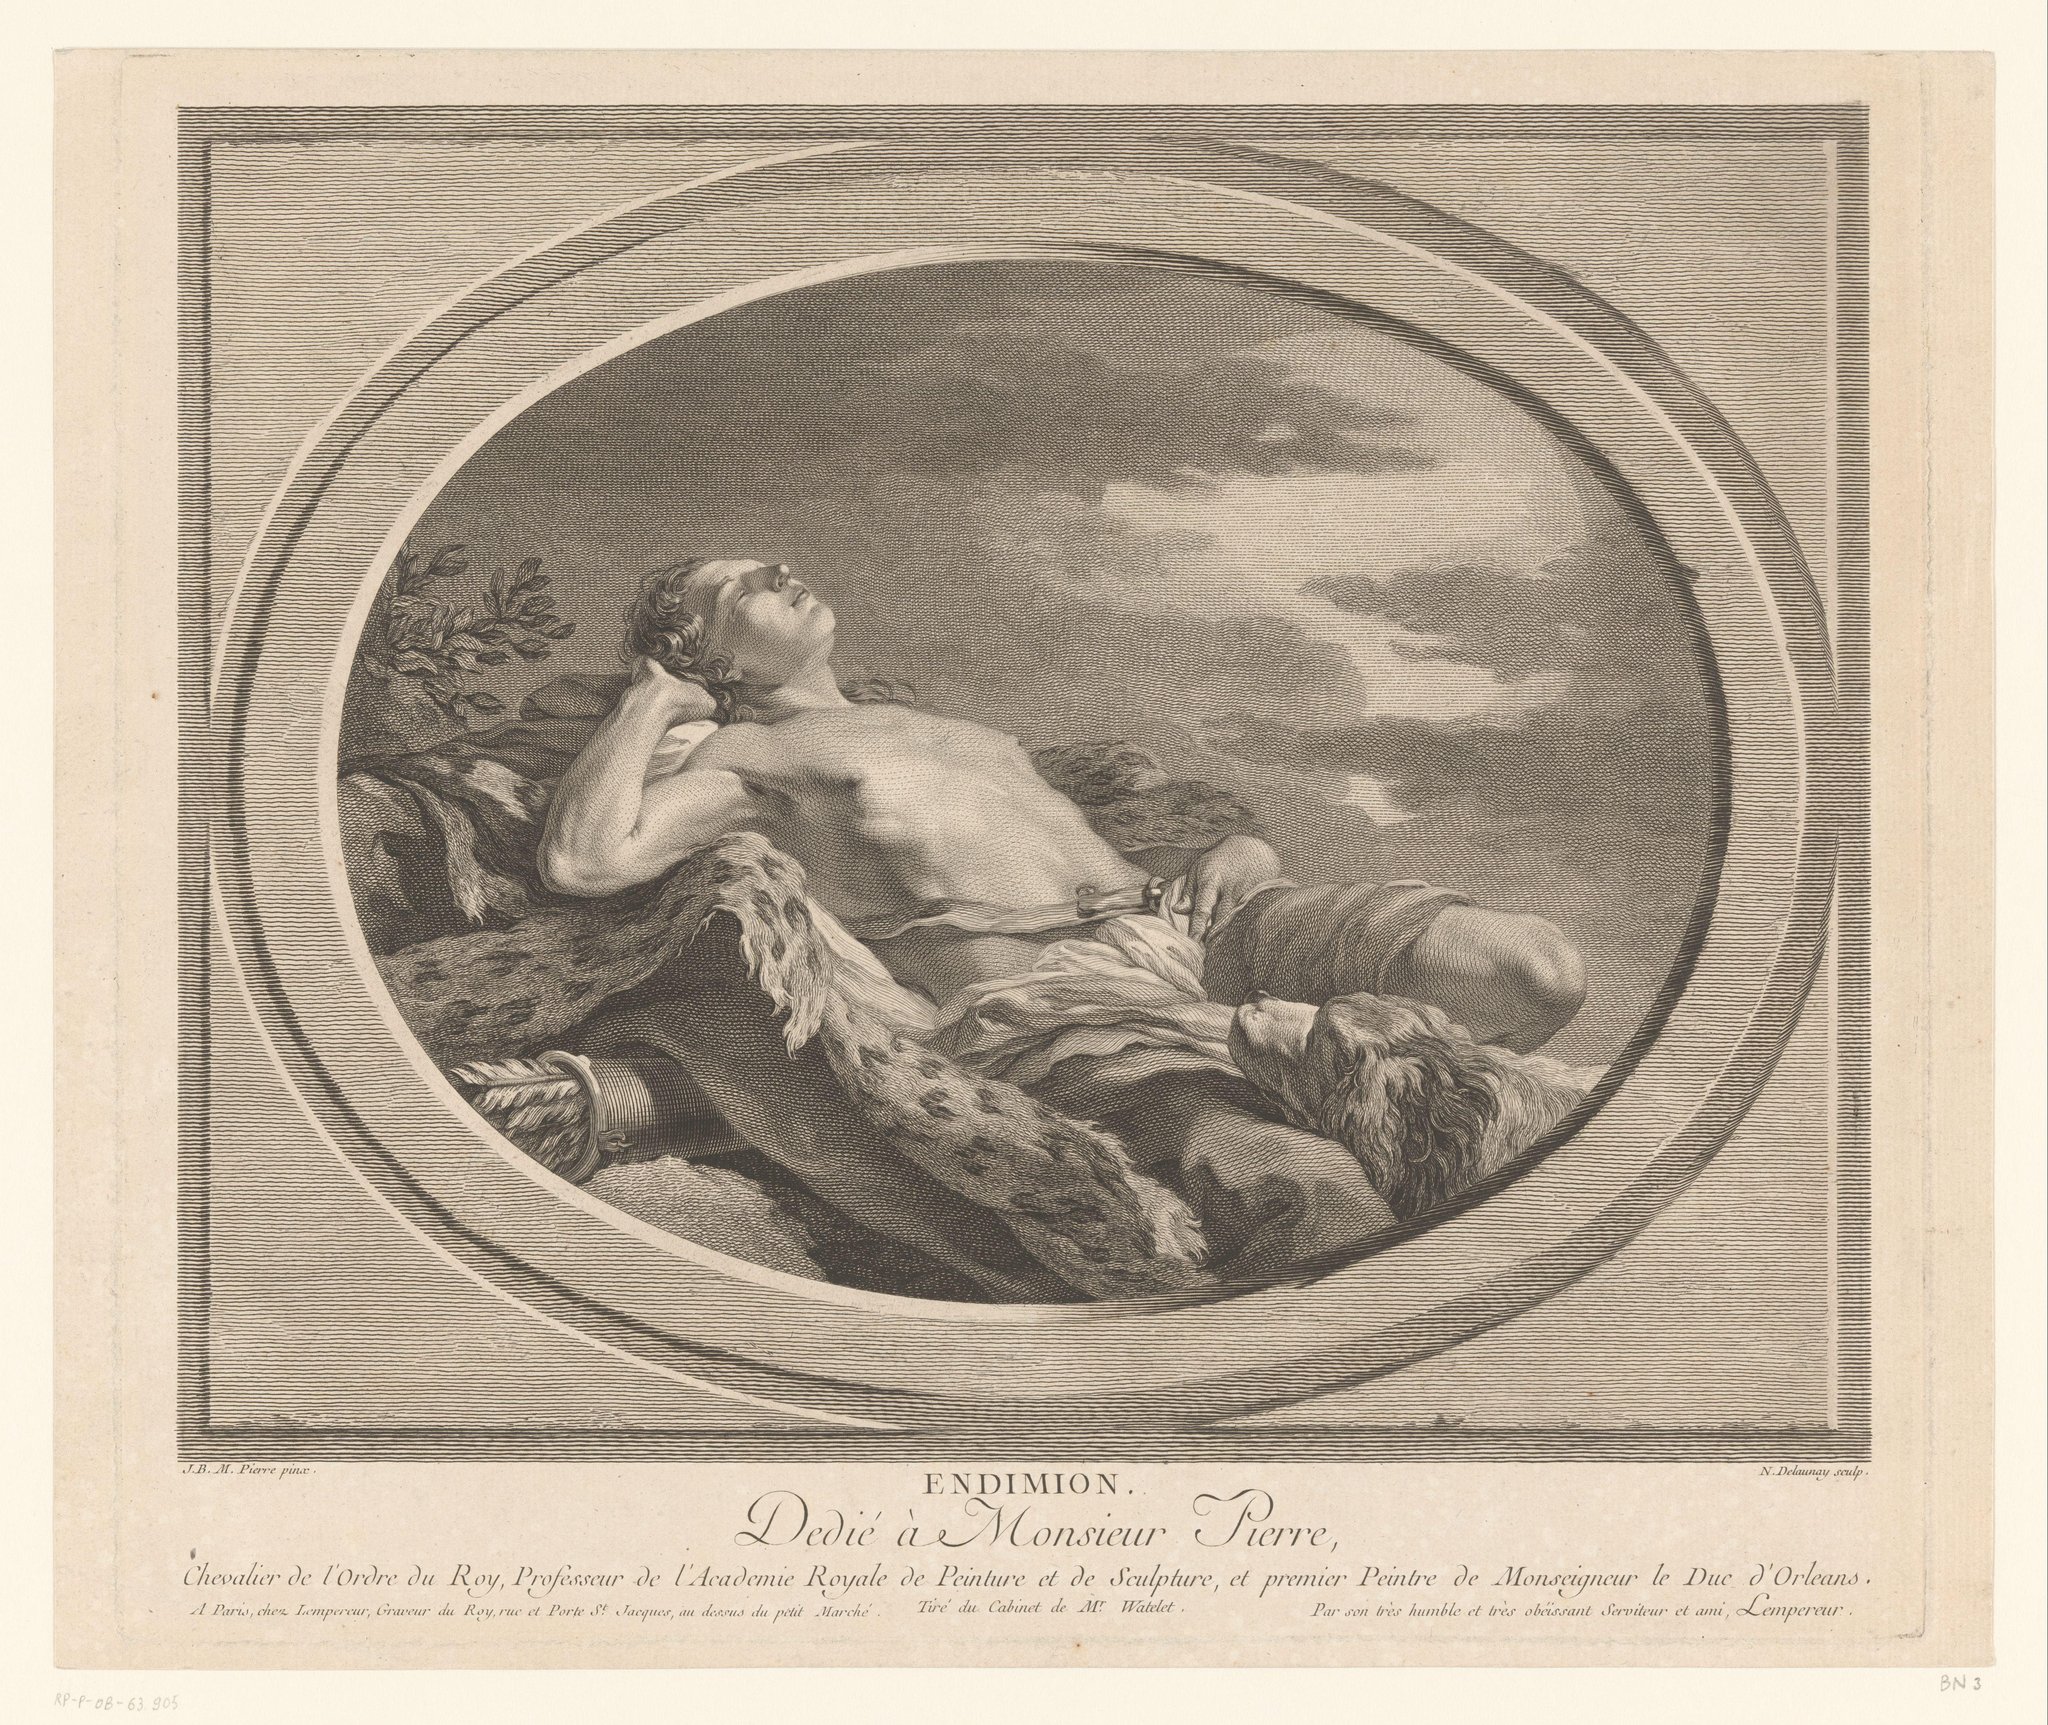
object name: print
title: Endymion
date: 1763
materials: paper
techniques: engraving, etching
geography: paris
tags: diana (luna) visiting the sleeping endymion, sleeping; unconsciousness - bb - out of doors, dog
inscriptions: collector's mark: Lugt 2228